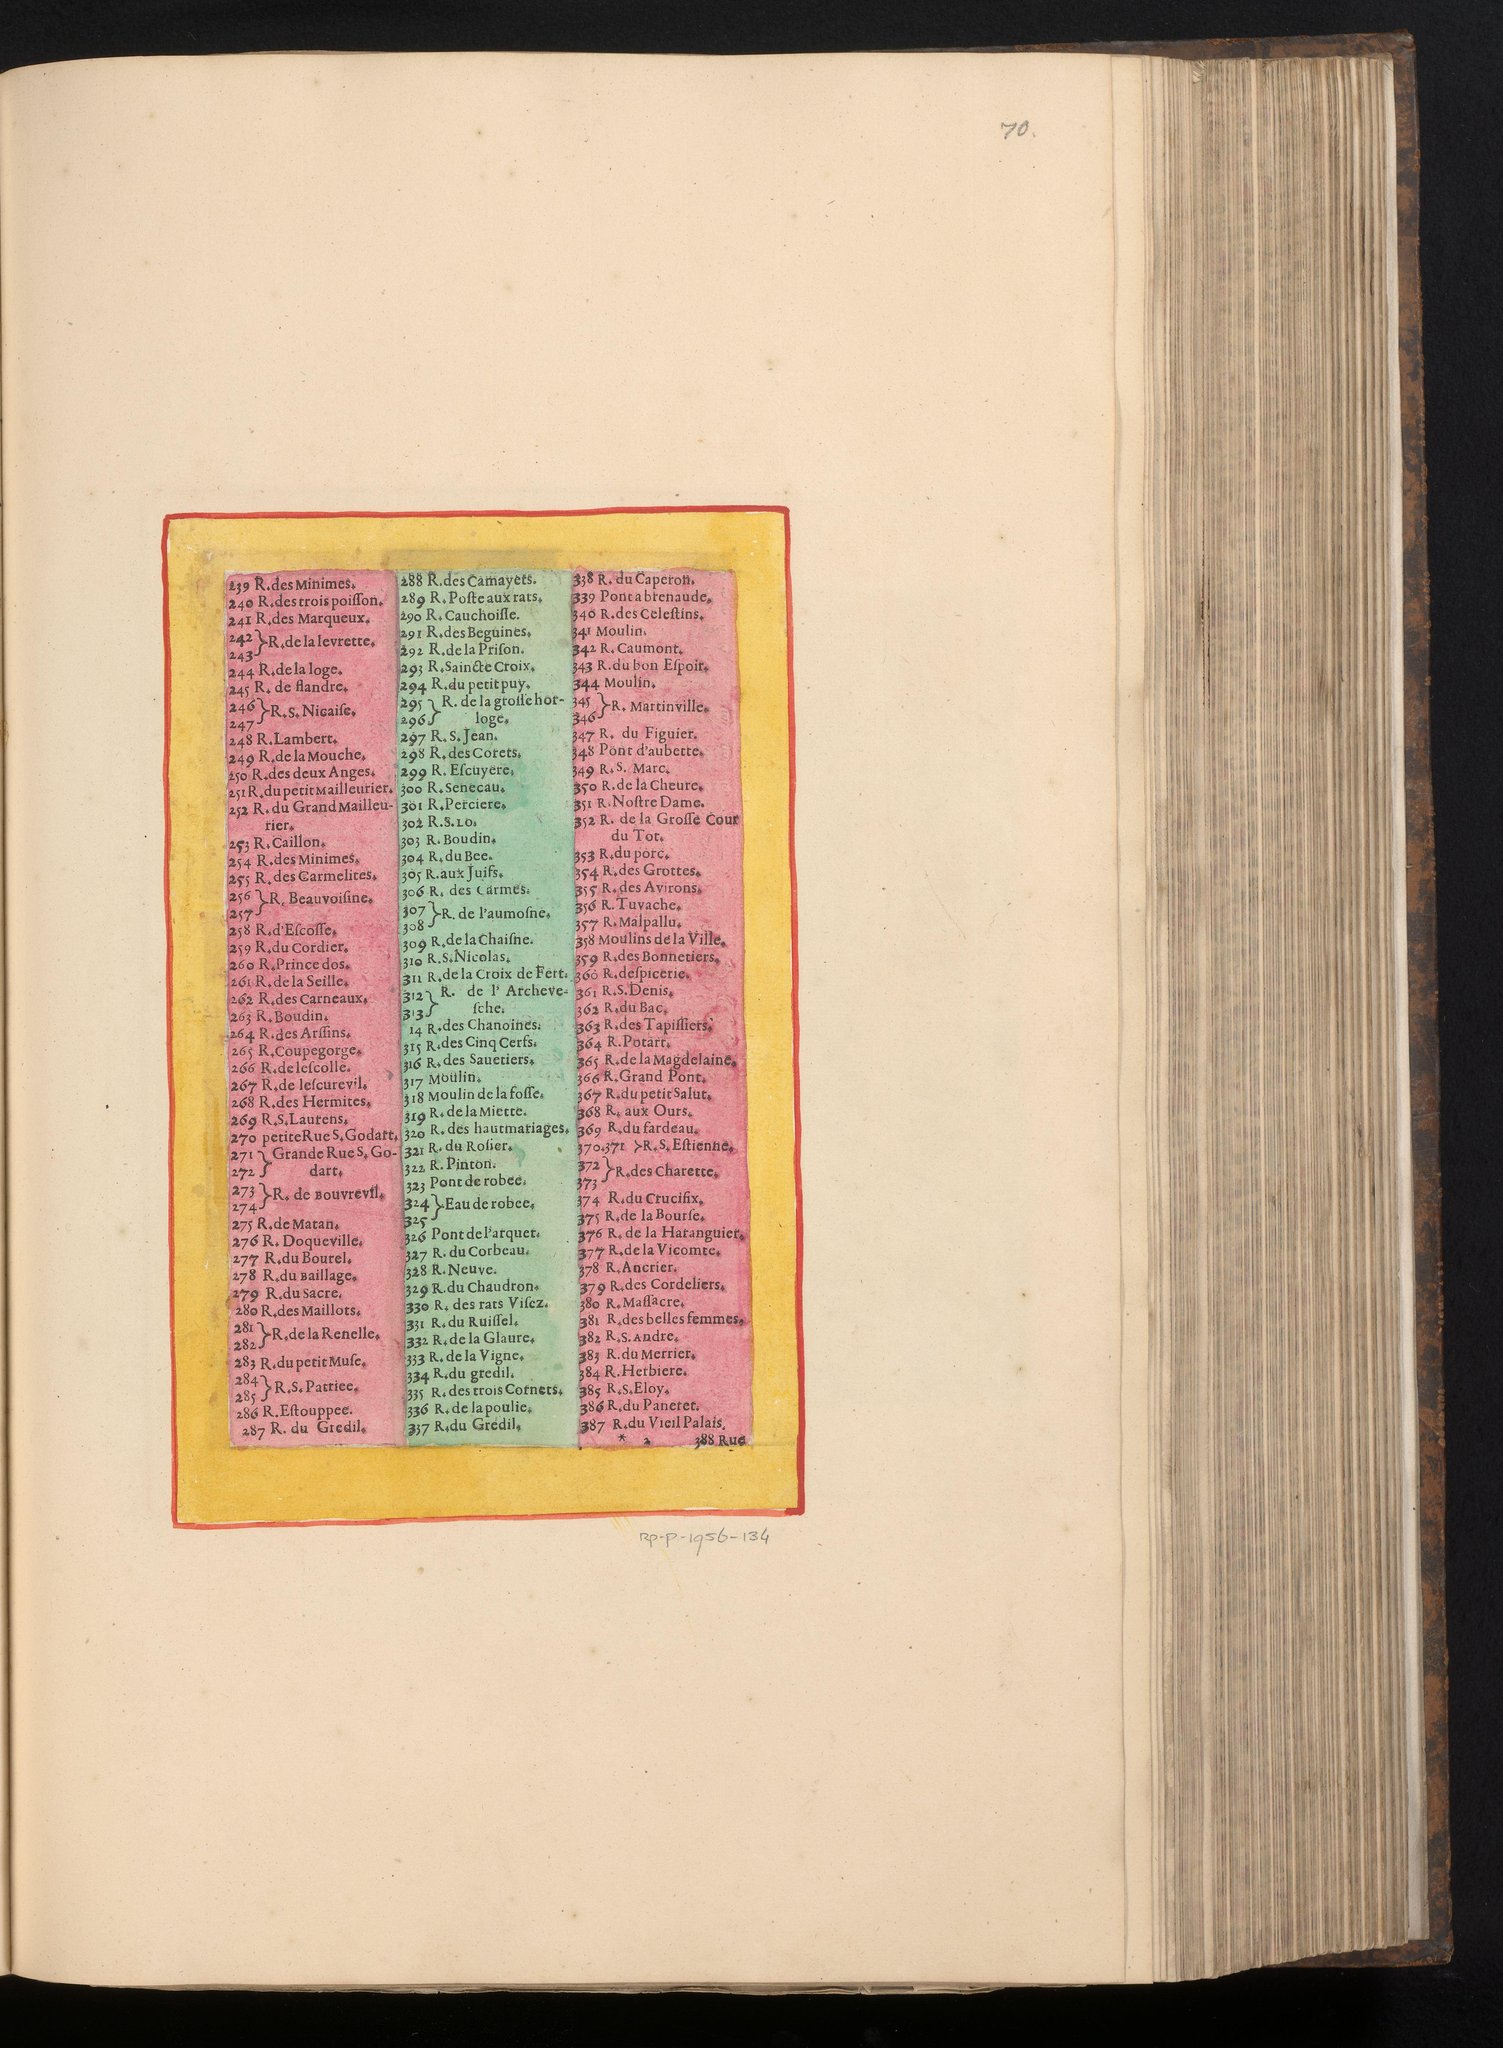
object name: album leaf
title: Derde deel (van vier) van de legenda bij een plattegrond van Rouen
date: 1657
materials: paper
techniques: hand coloring, letterpress printing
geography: frankfurt am main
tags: rouen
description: De tekst beschrijft nummers 239 tot en met 387 op een kaart van Rouen. De bijbehorende kaart zit in ditzelfde album voor de legenda (RP-P-1956-131). Deze prent maakt deel uit van een album.